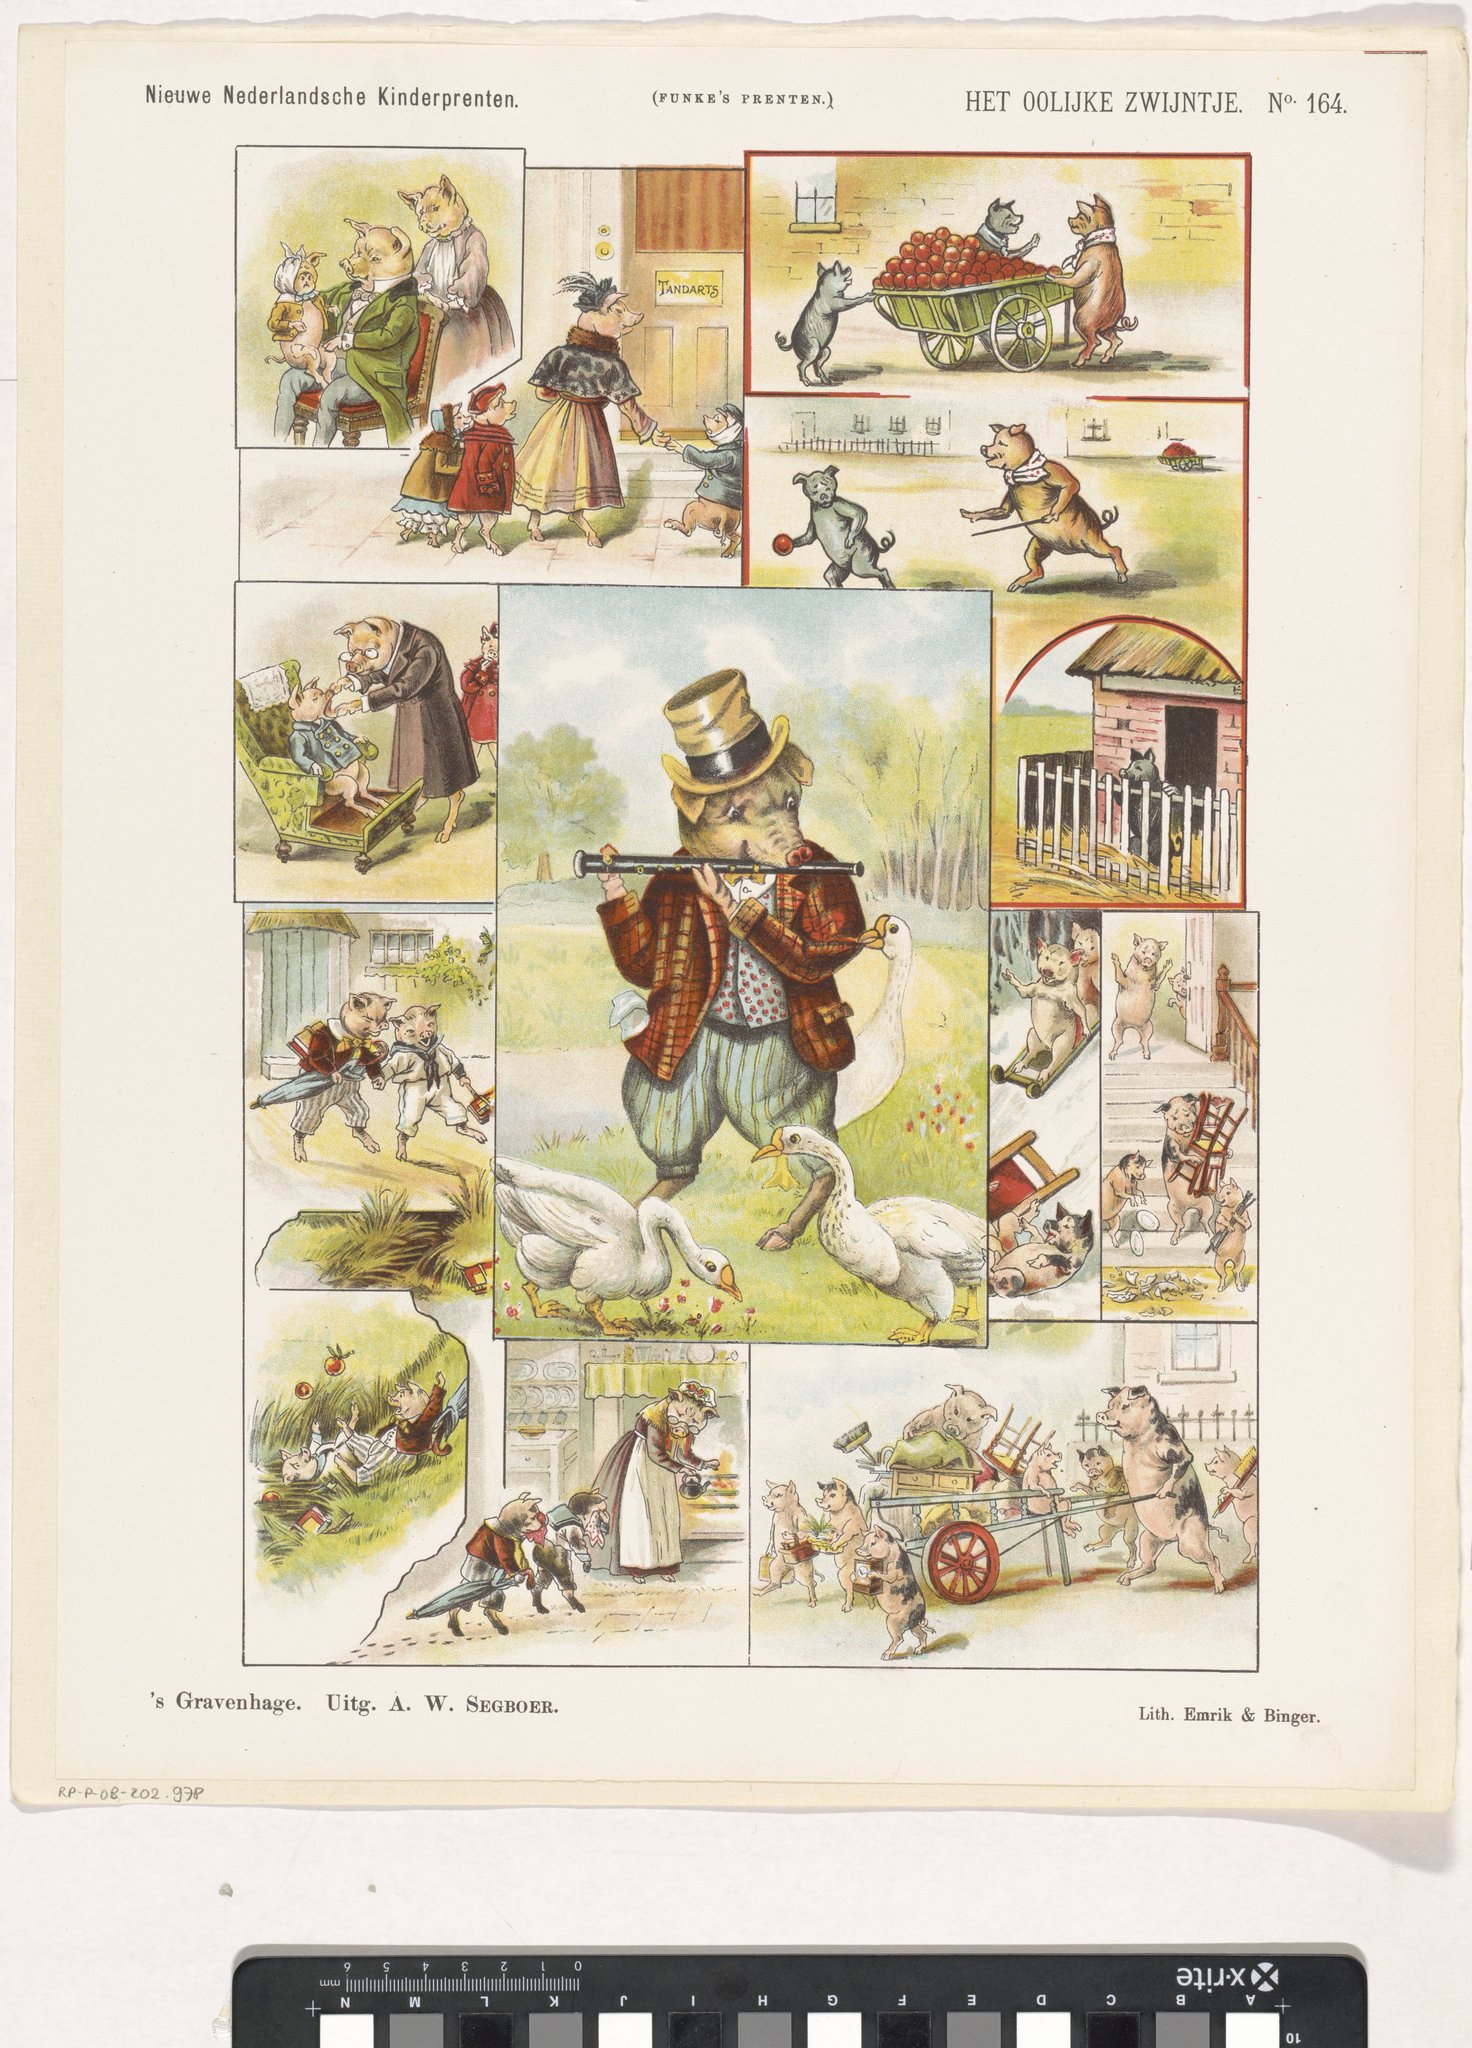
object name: print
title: Het oolijke zwijntje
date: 1903-1919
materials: paper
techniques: lithograph, letterpress printing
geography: haarlem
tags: pig, animals acting as human beings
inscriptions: collector's mark: Lugt 2760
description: Blad met 13 voorstellingen van varkens die zich als mensen gedragen, waaronder voorstellingen van varkens die naar de tandarts gaan, een varken die dwarsfluit speelt en varkens die verhuizen. Genummerd rechtsboven: No. 164.